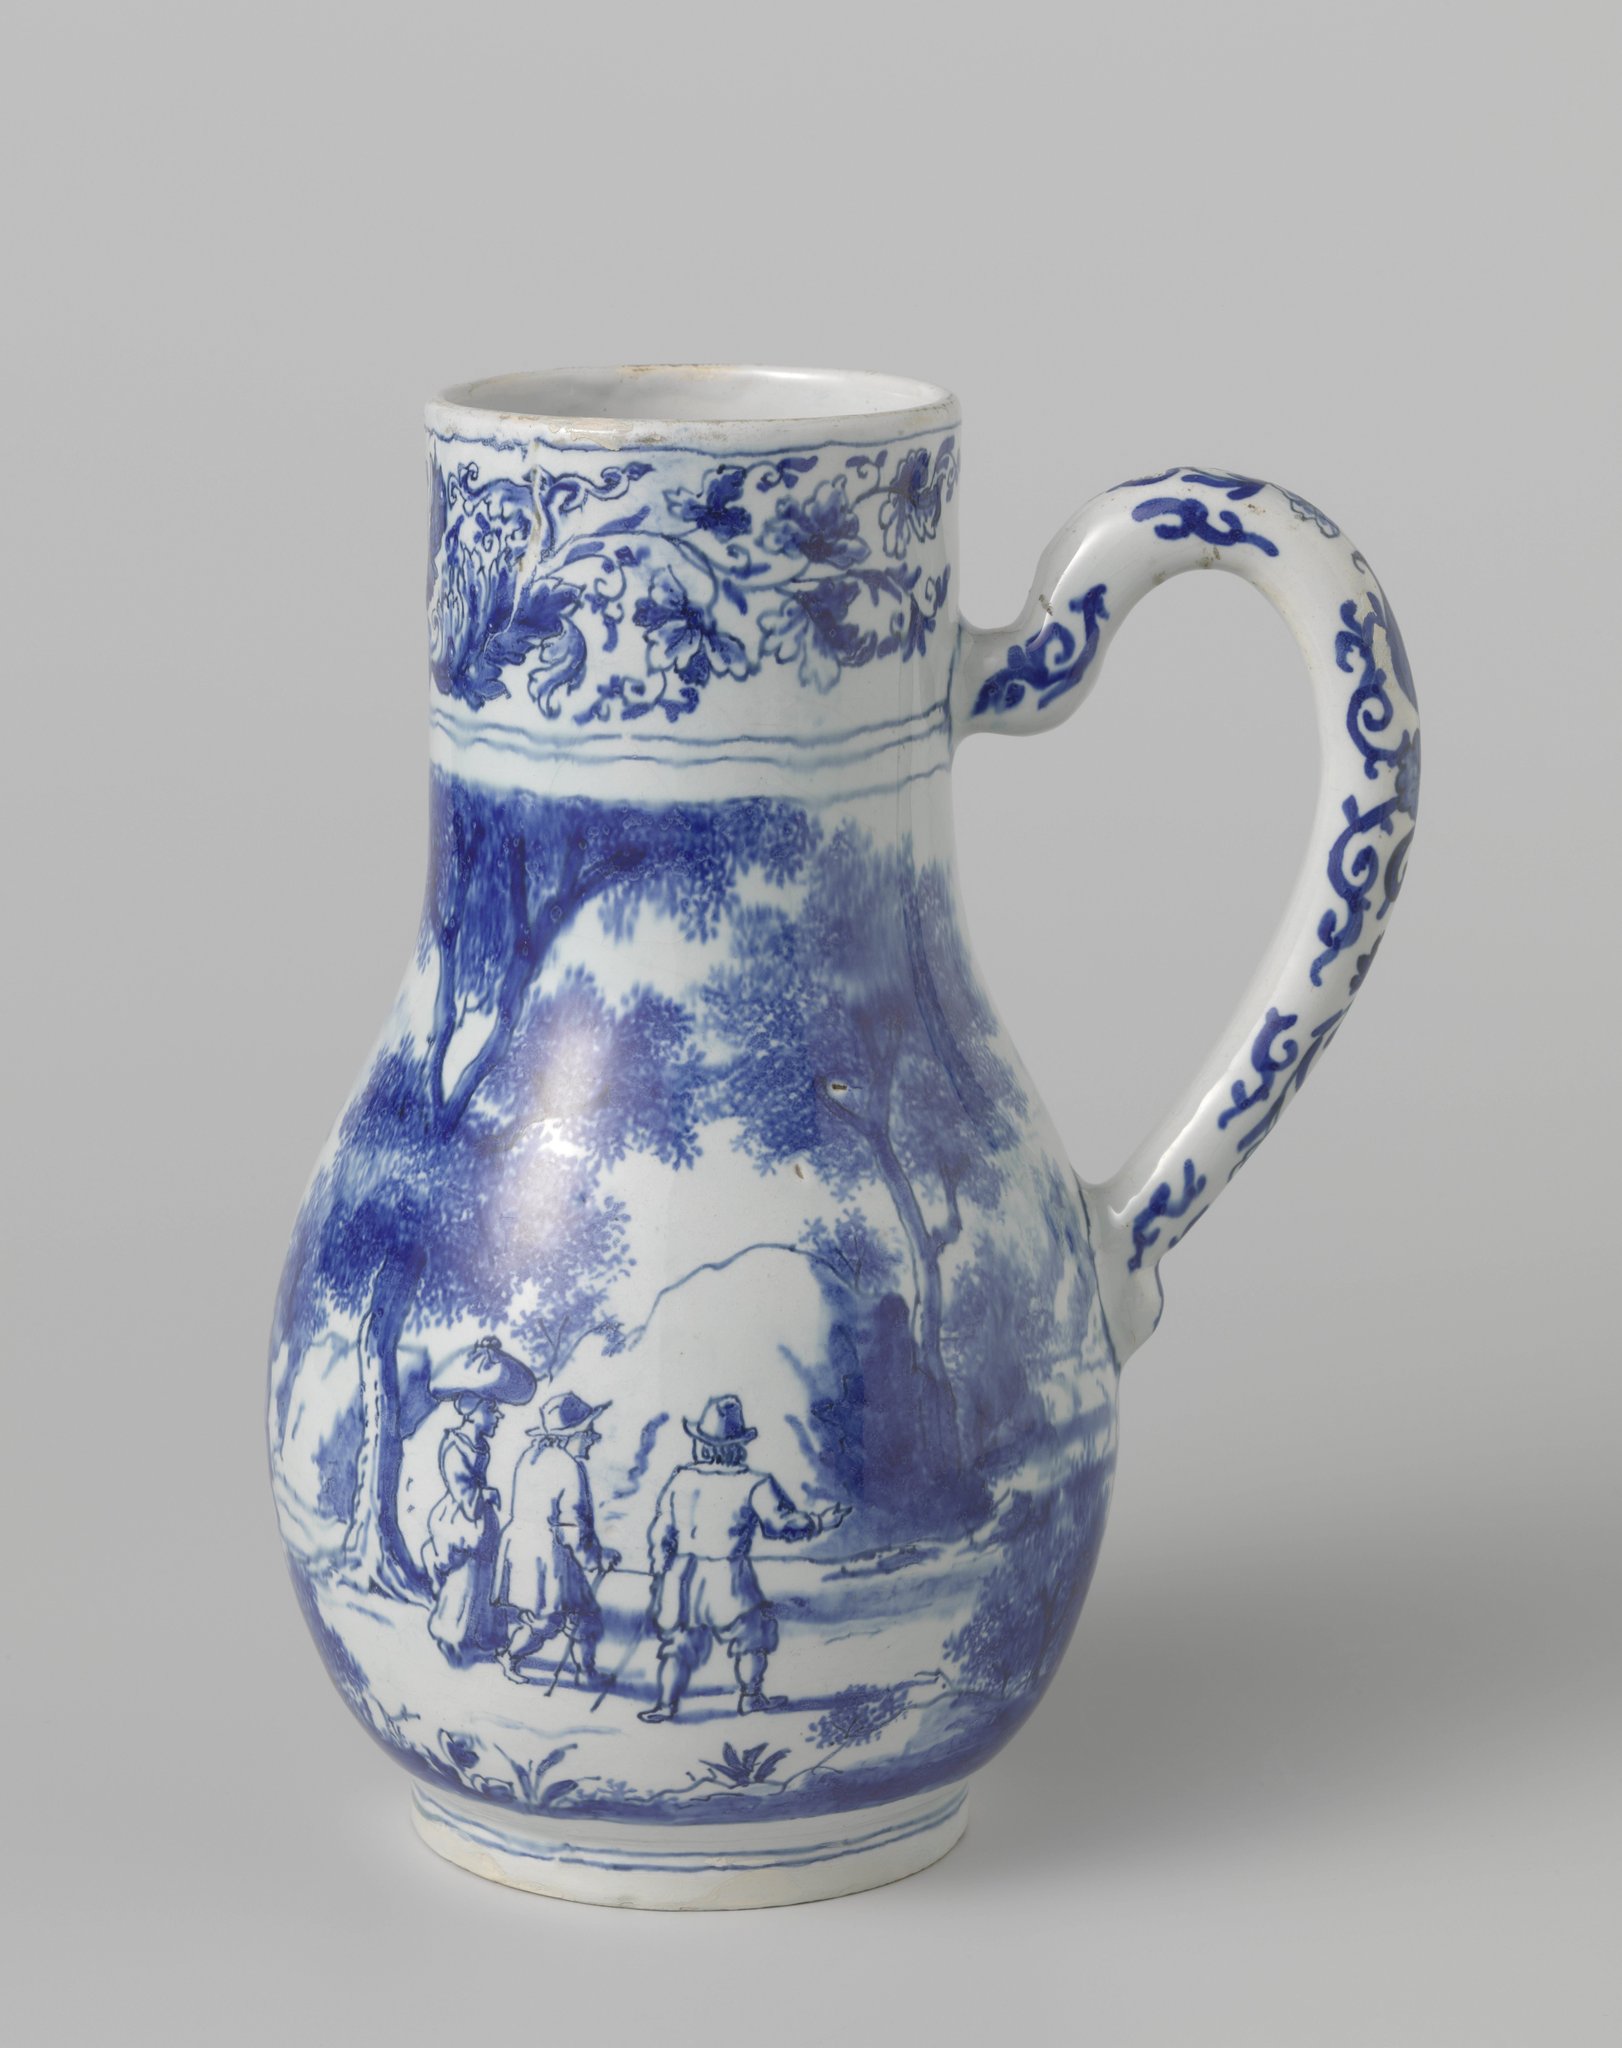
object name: ewer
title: Three decorated jugs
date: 1694-1712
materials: earthenware, glaze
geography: delft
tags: landscapes in the temperate zone, 'en route', traveller under way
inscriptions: mark: ‘RooS.’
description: Between 1705 and 1711, both the De Roos and the De Witte Ster pottery factories were in the hands of the same owners. There must have been a lively exchange of motifs and painters, for it is impossible to distinguish between the objects made in either factory during those years.